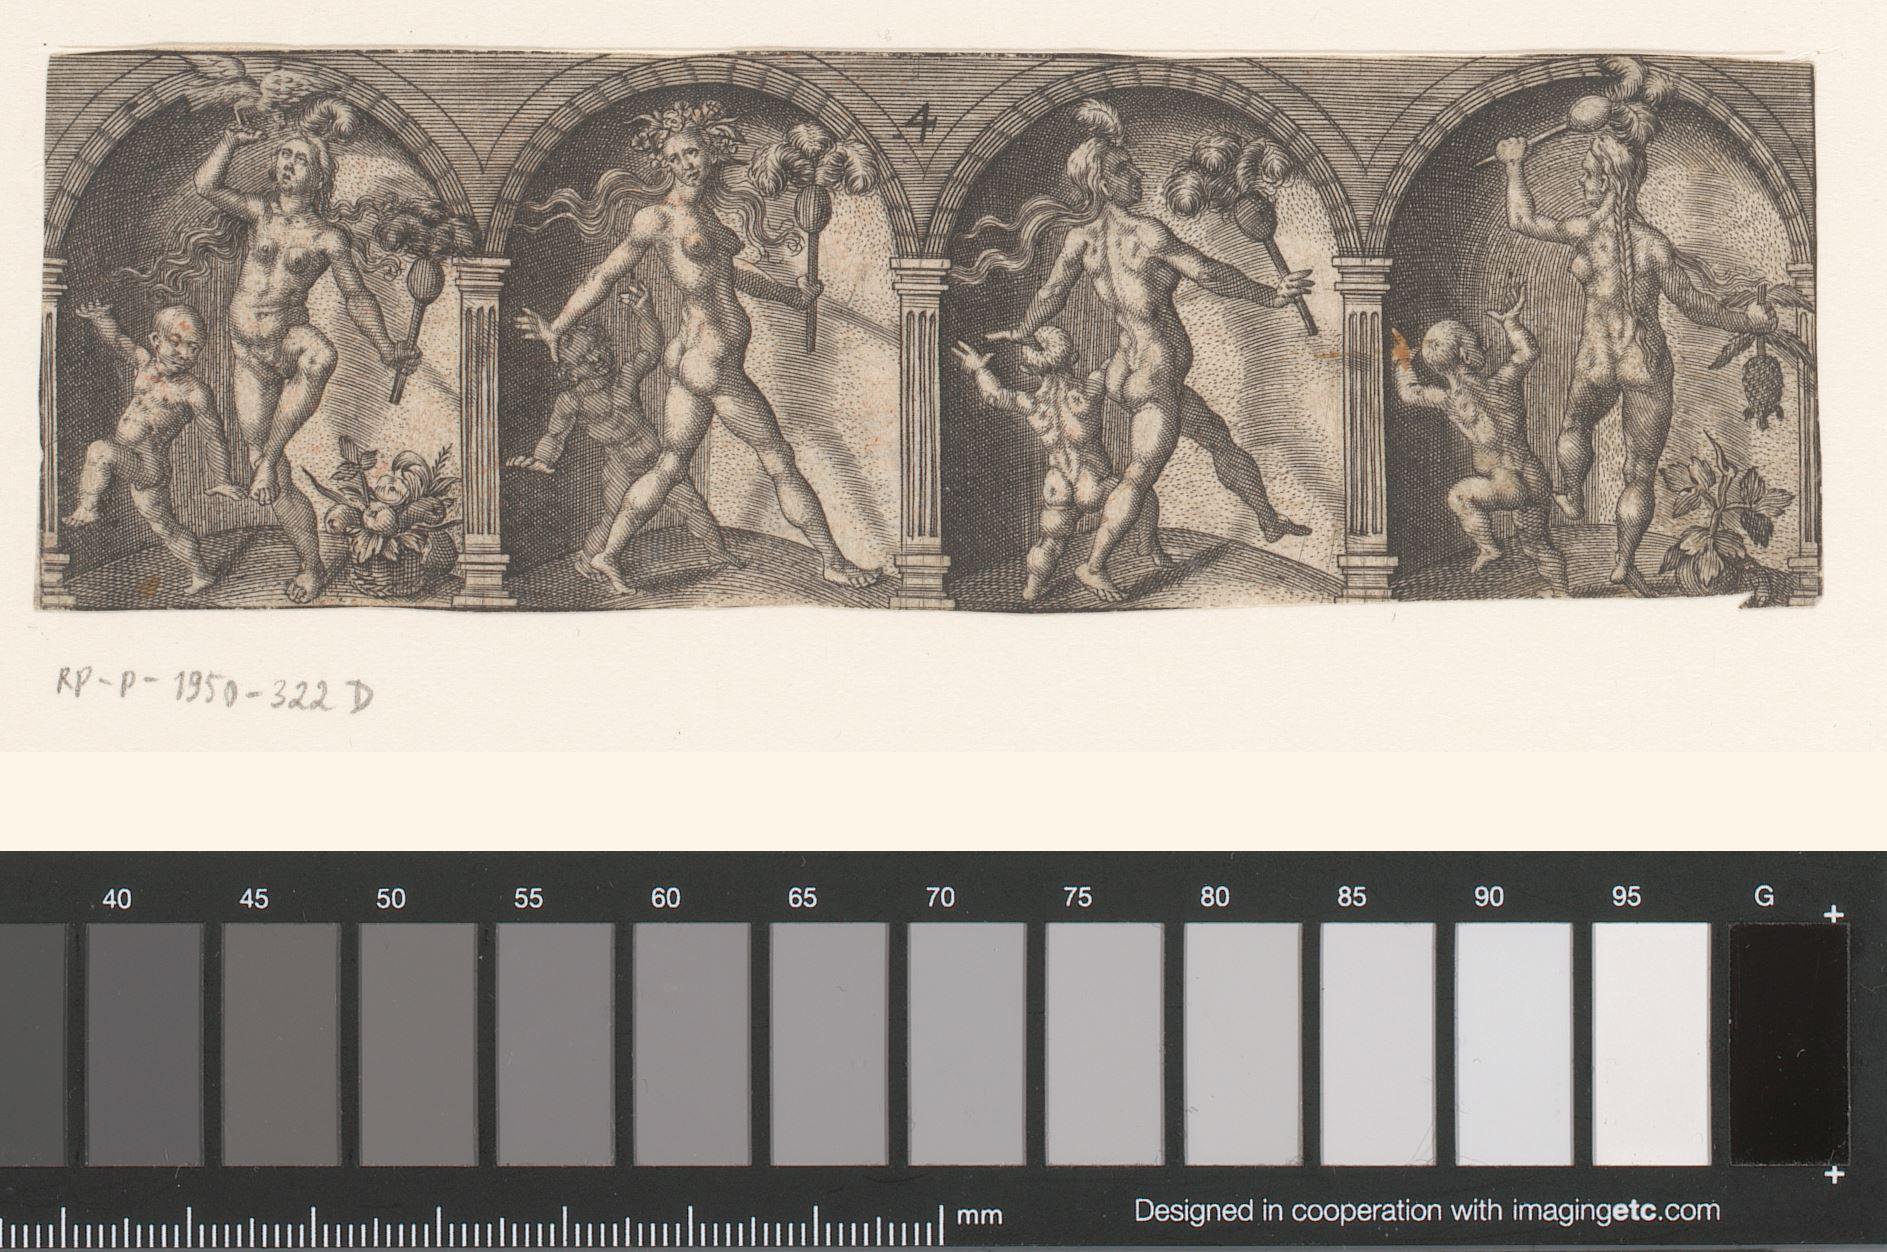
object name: print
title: Les Divers Pourtraicts & figures faictes sus les meurs Des habitans du Nouveau Monde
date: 1610-1640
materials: paper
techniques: engraving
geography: france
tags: parts of church interior: niche, woman (showing herself) undressed, quasi-nude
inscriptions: collector's mark: Lugt 2228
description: In deze serie worden naakte figuren in vier architecturale niches geplaatst. Zij stellen de inwoners voor van de Nieuwe Wereld.